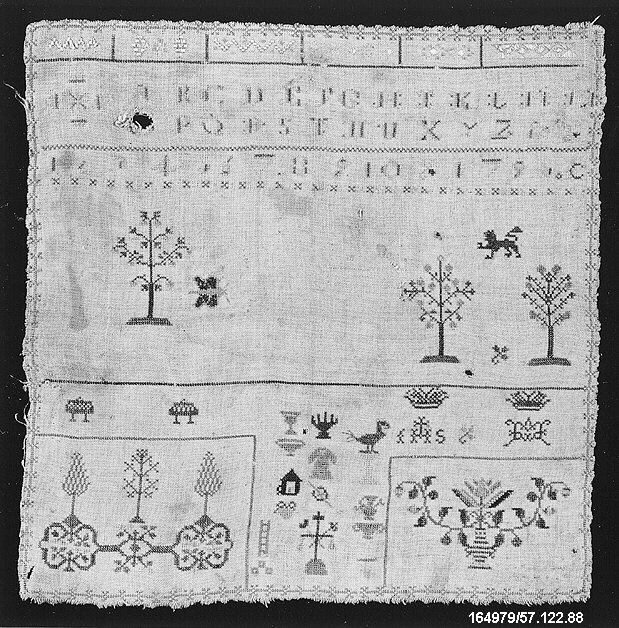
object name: sampler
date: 1795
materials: linen, silk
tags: animals,trees